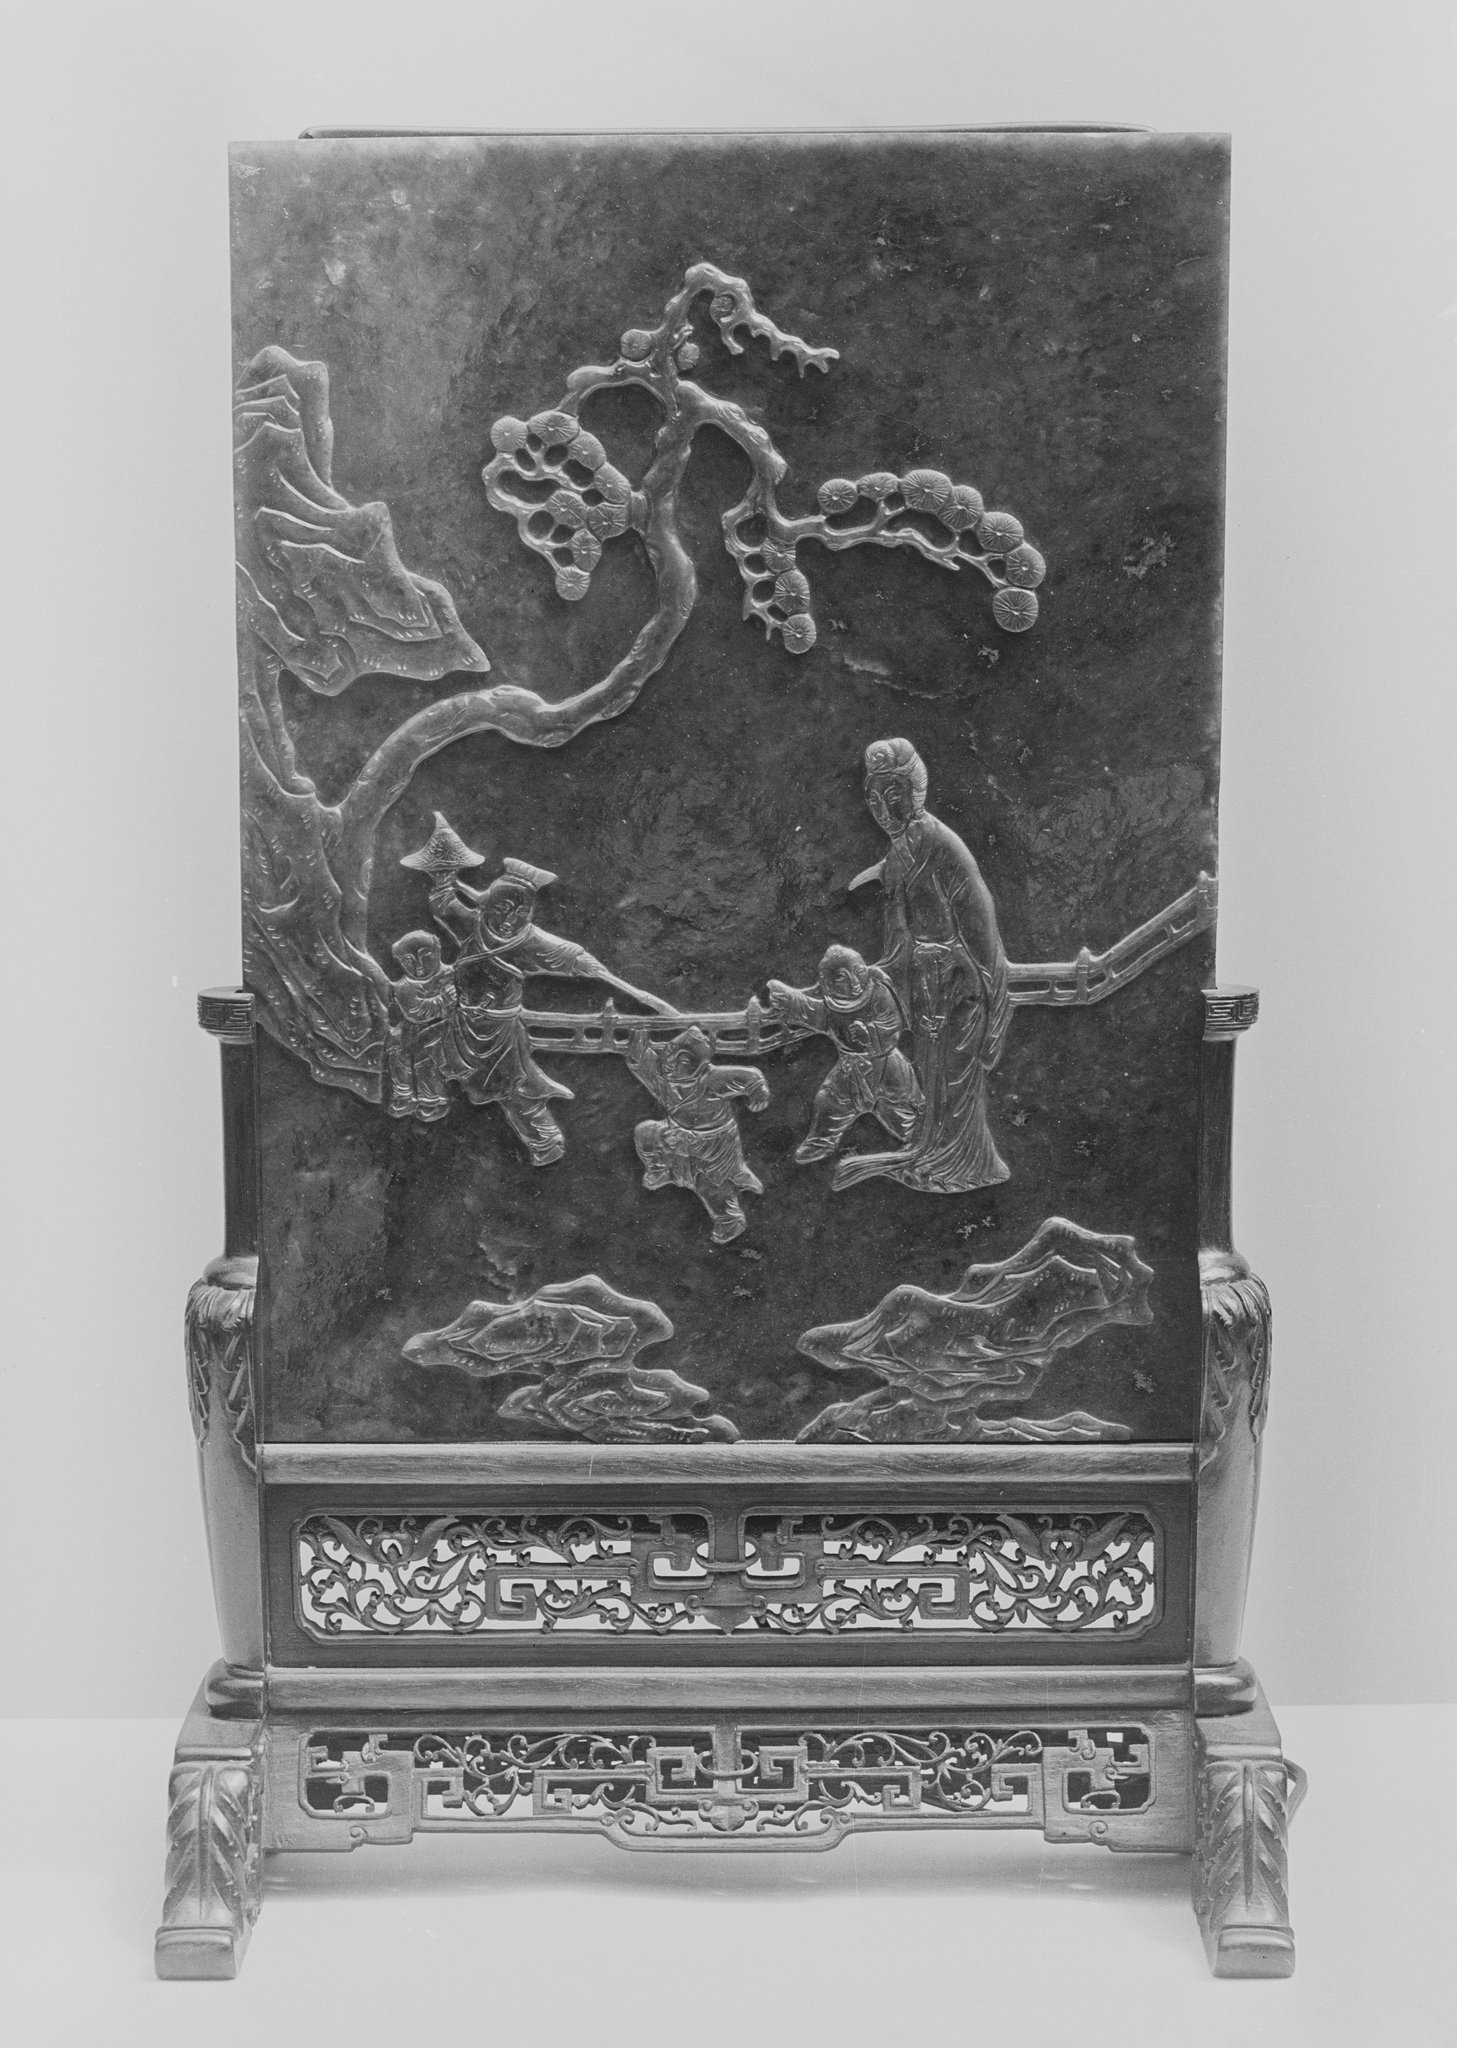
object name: table screen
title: Table screen with a woman and boys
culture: chinese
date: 1801-1900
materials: jade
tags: boys,women